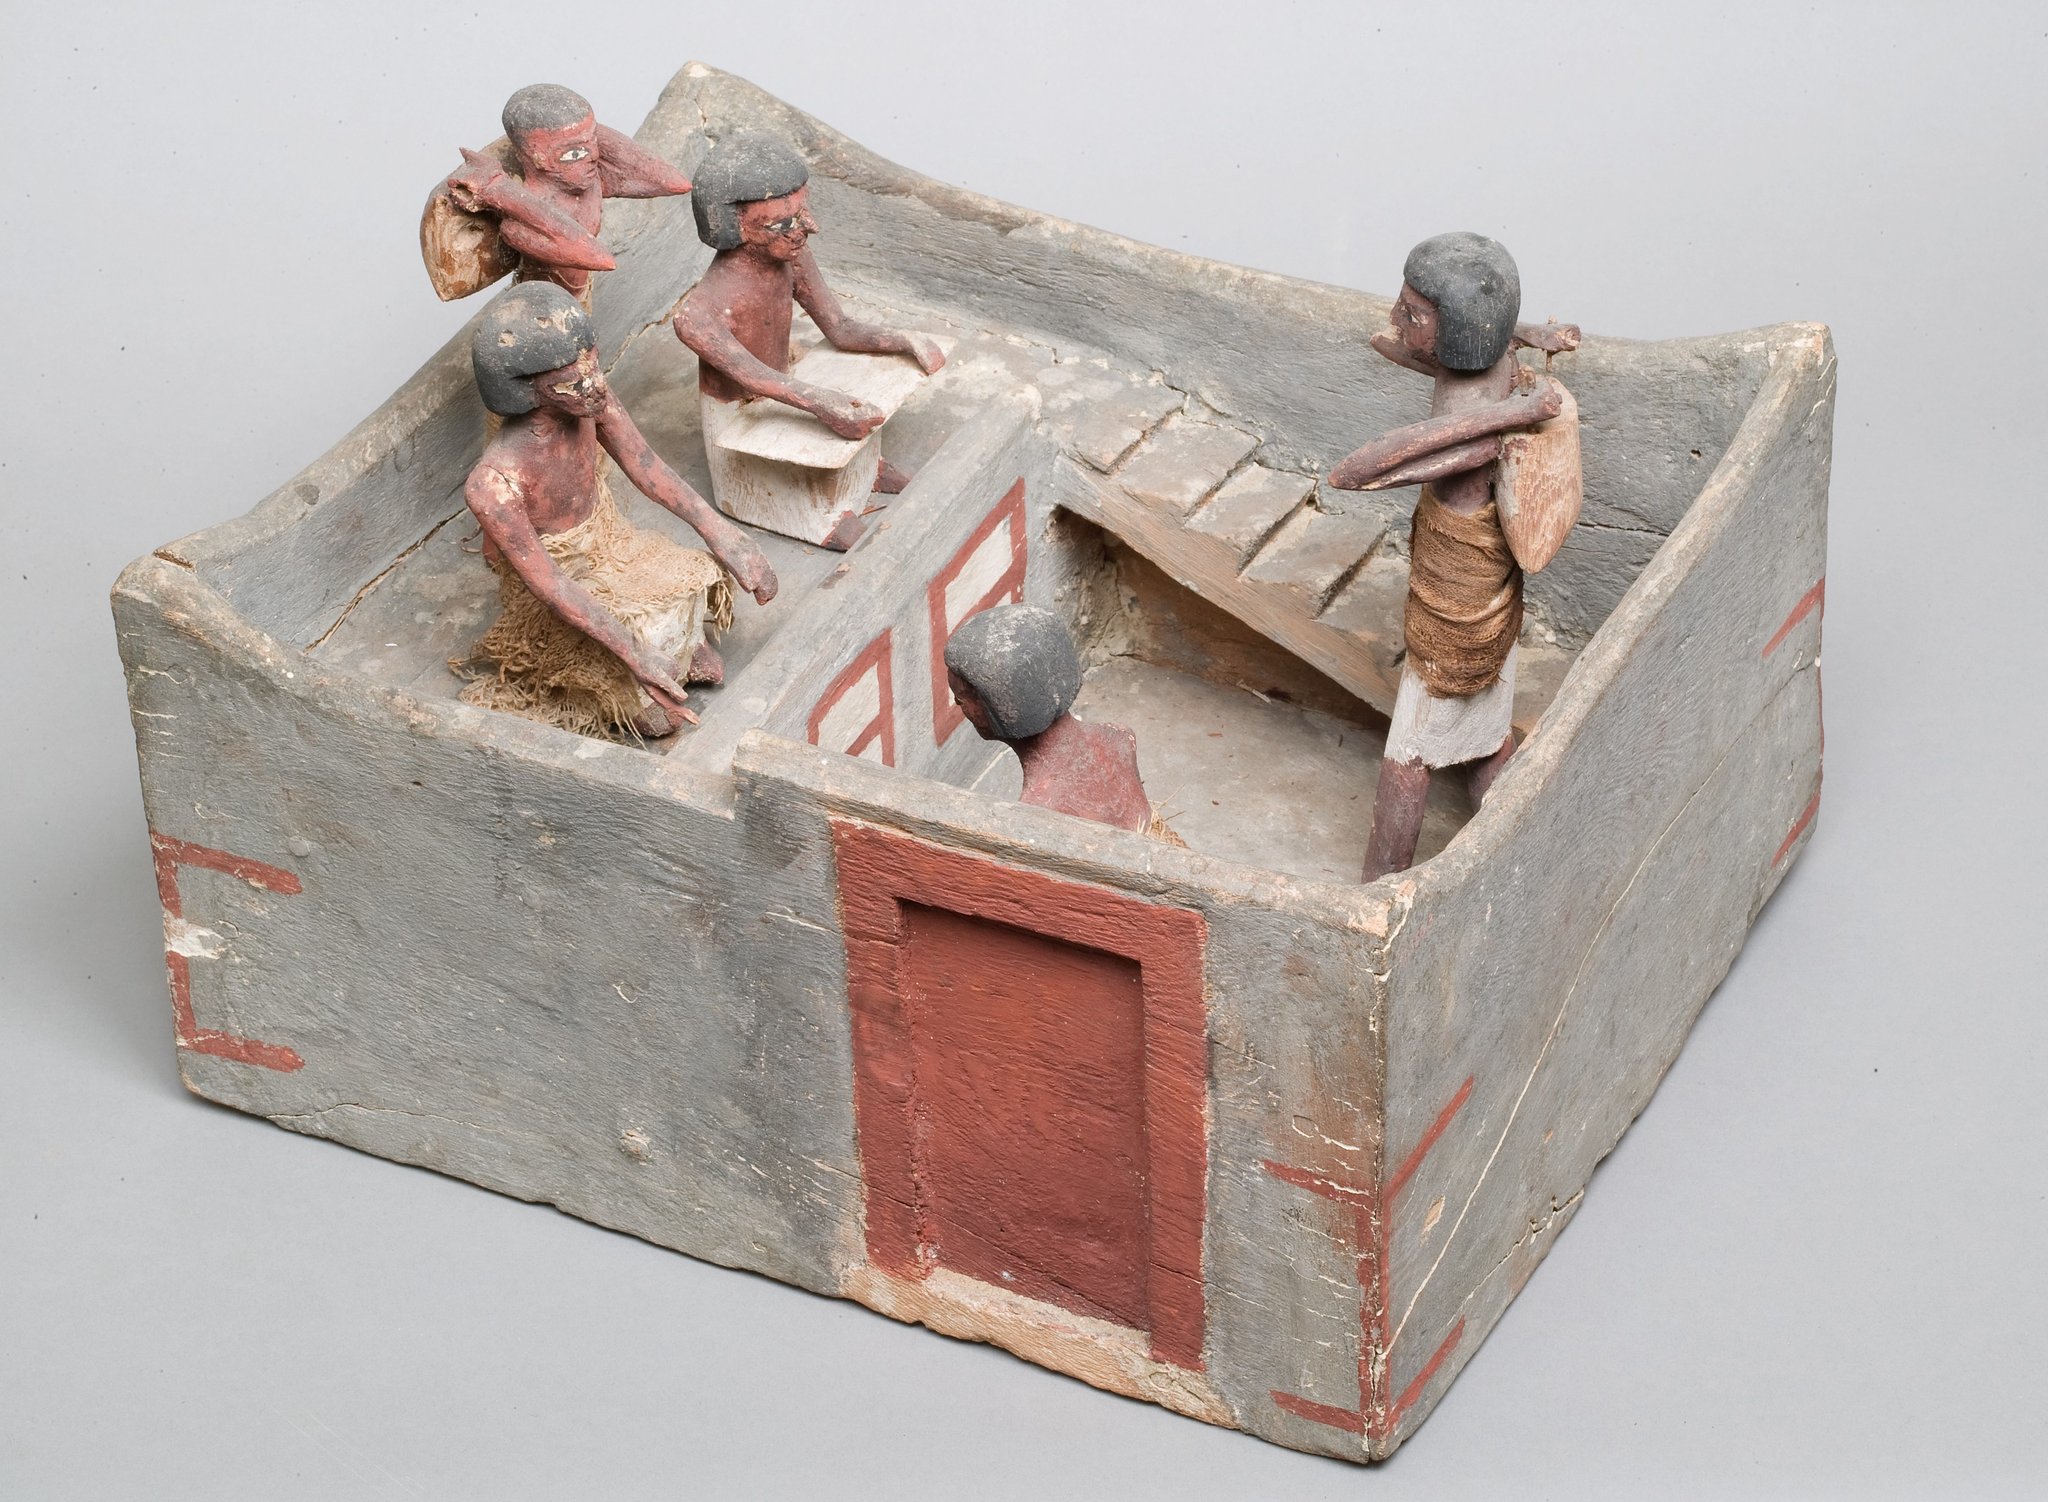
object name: model, granary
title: Model of a granary with scribe and overseer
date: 2030-1850 BCE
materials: wood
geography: egypt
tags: men,working